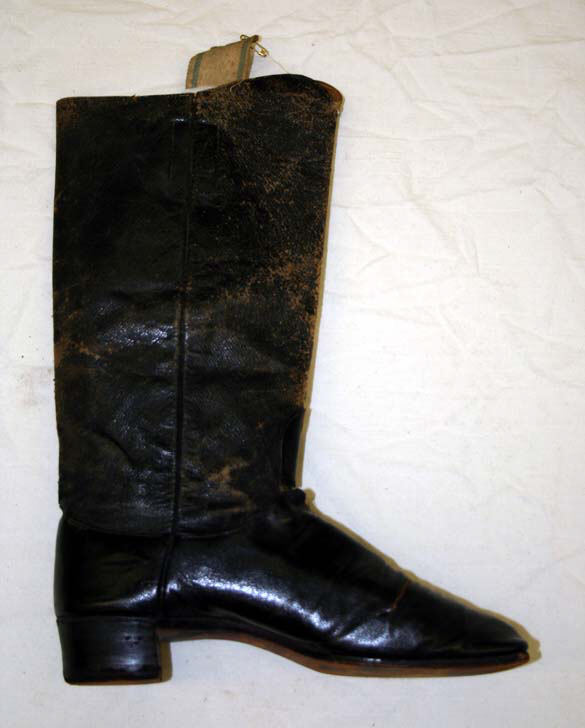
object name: riding boot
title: Riding boots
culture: american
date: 1830-1839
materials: leather